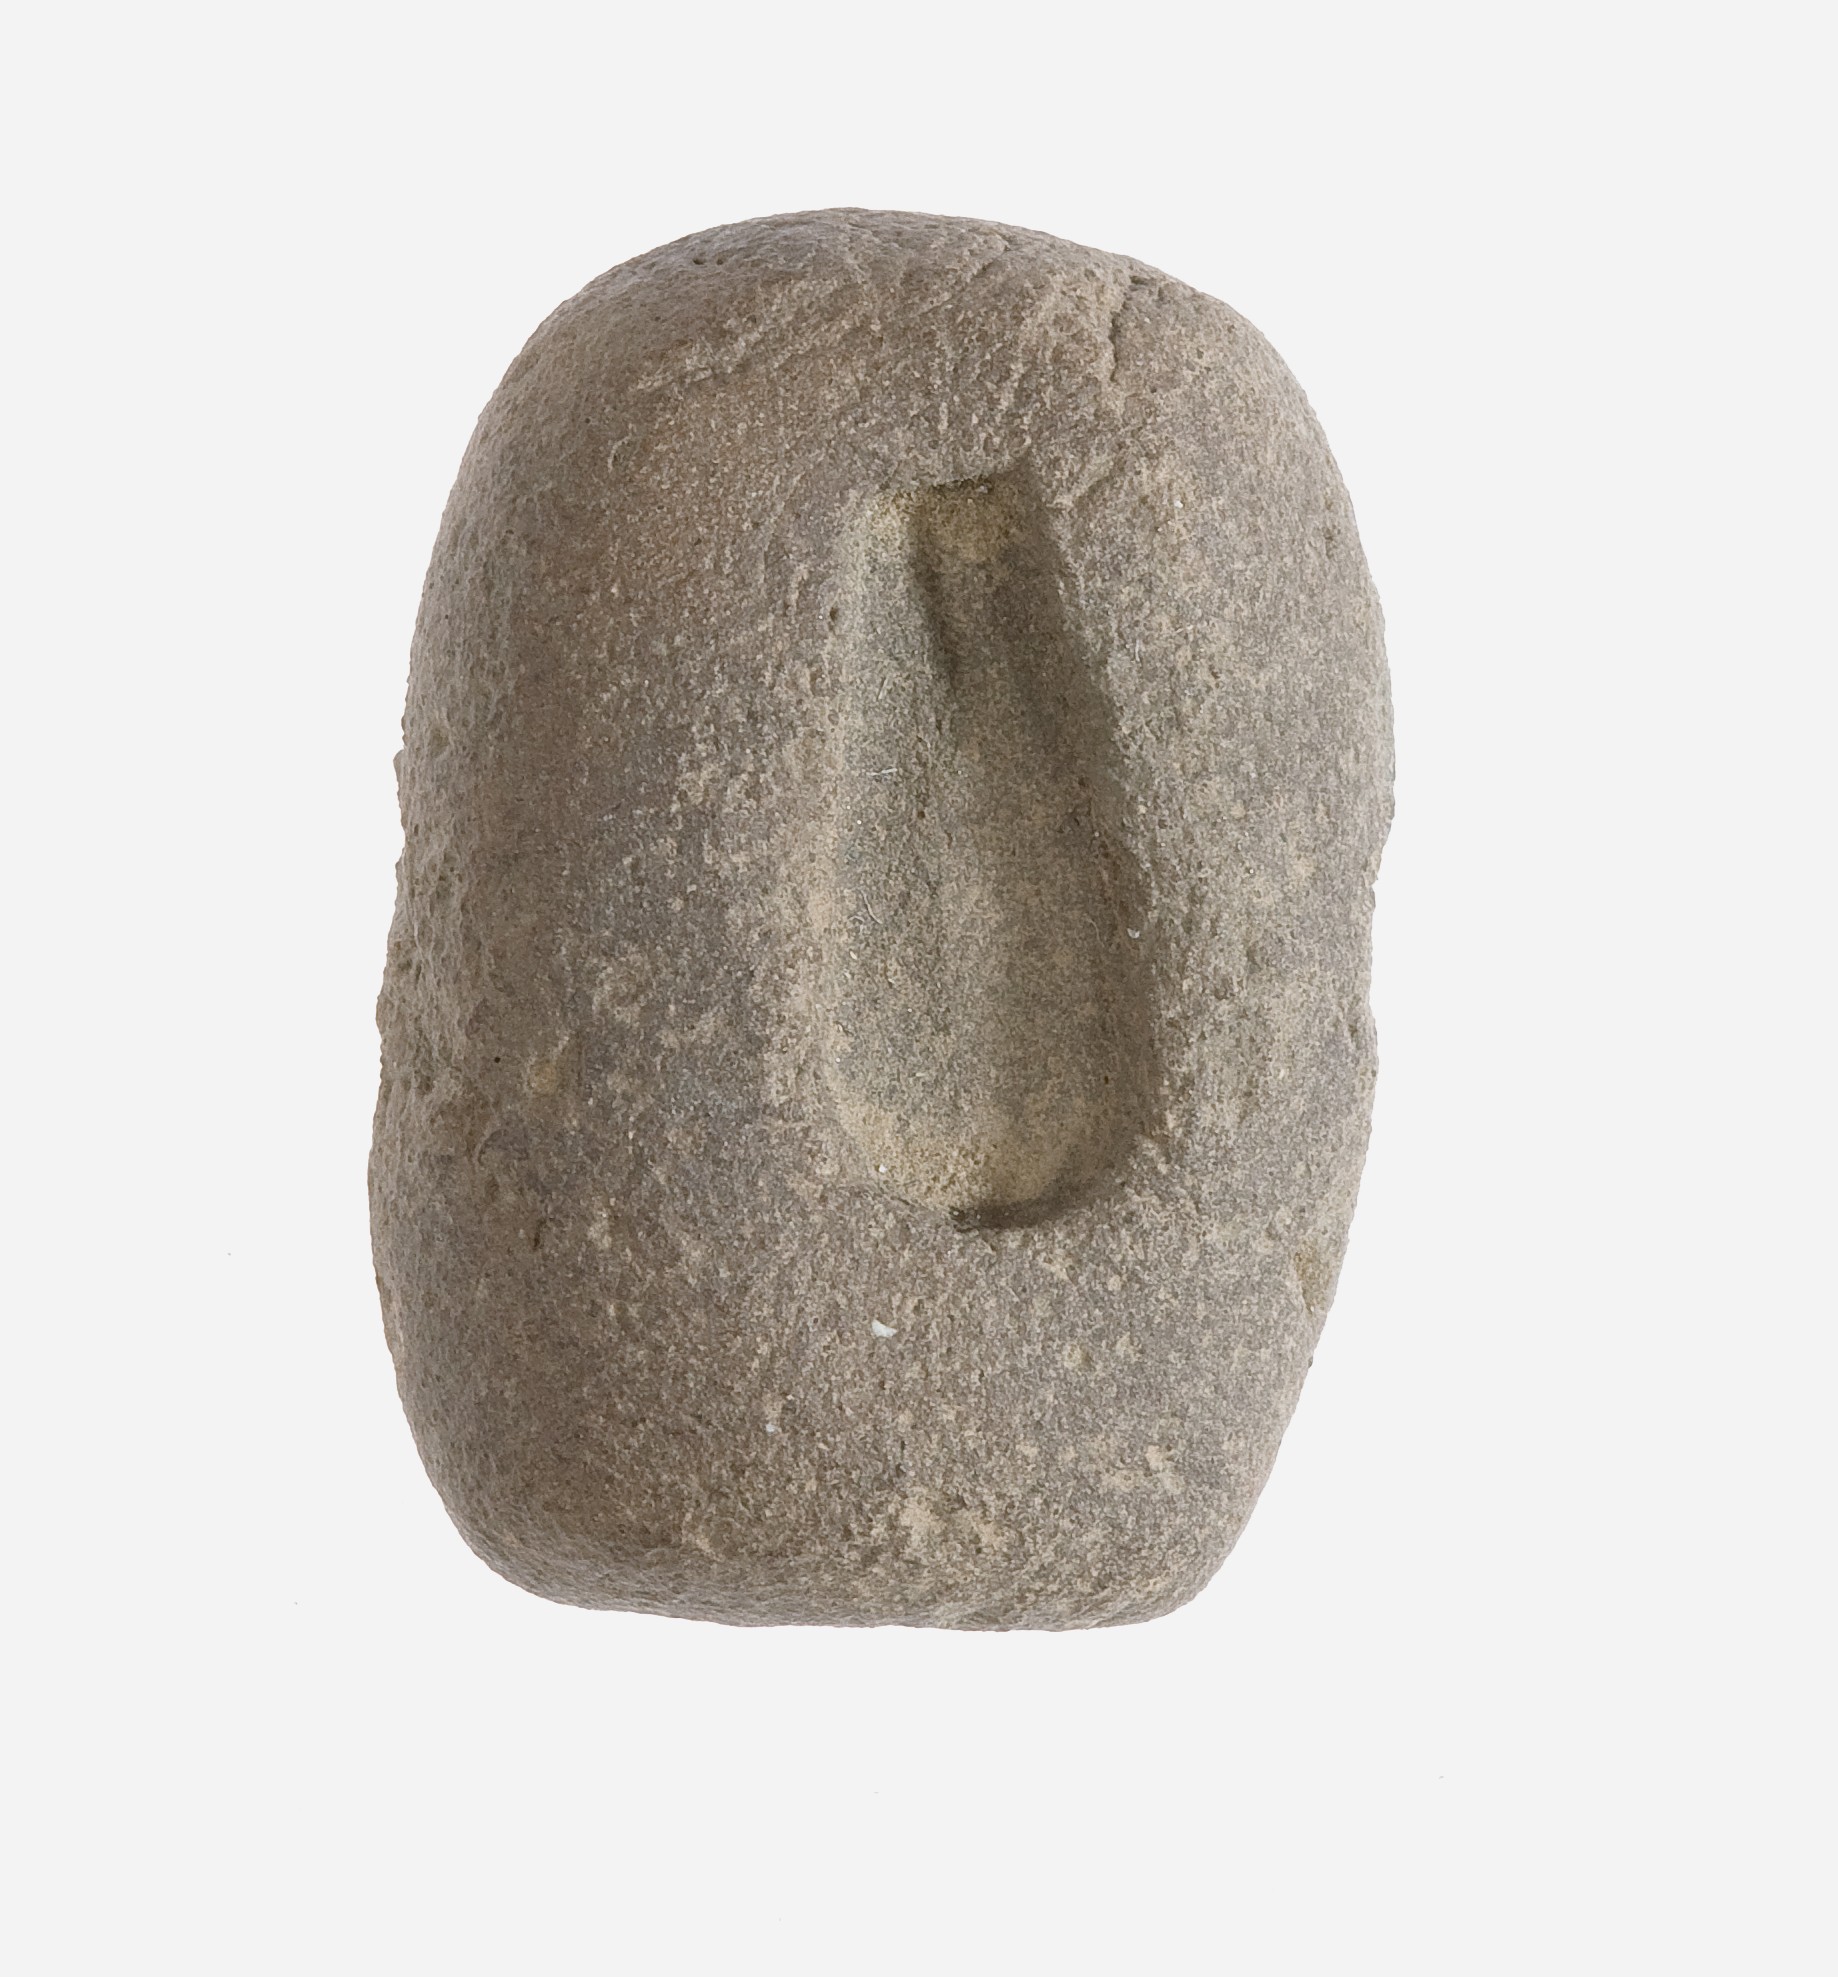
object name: mold, bead, drop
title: Mold for a Drop Bead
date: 1390-1352 BCE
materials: pottery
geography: egypt